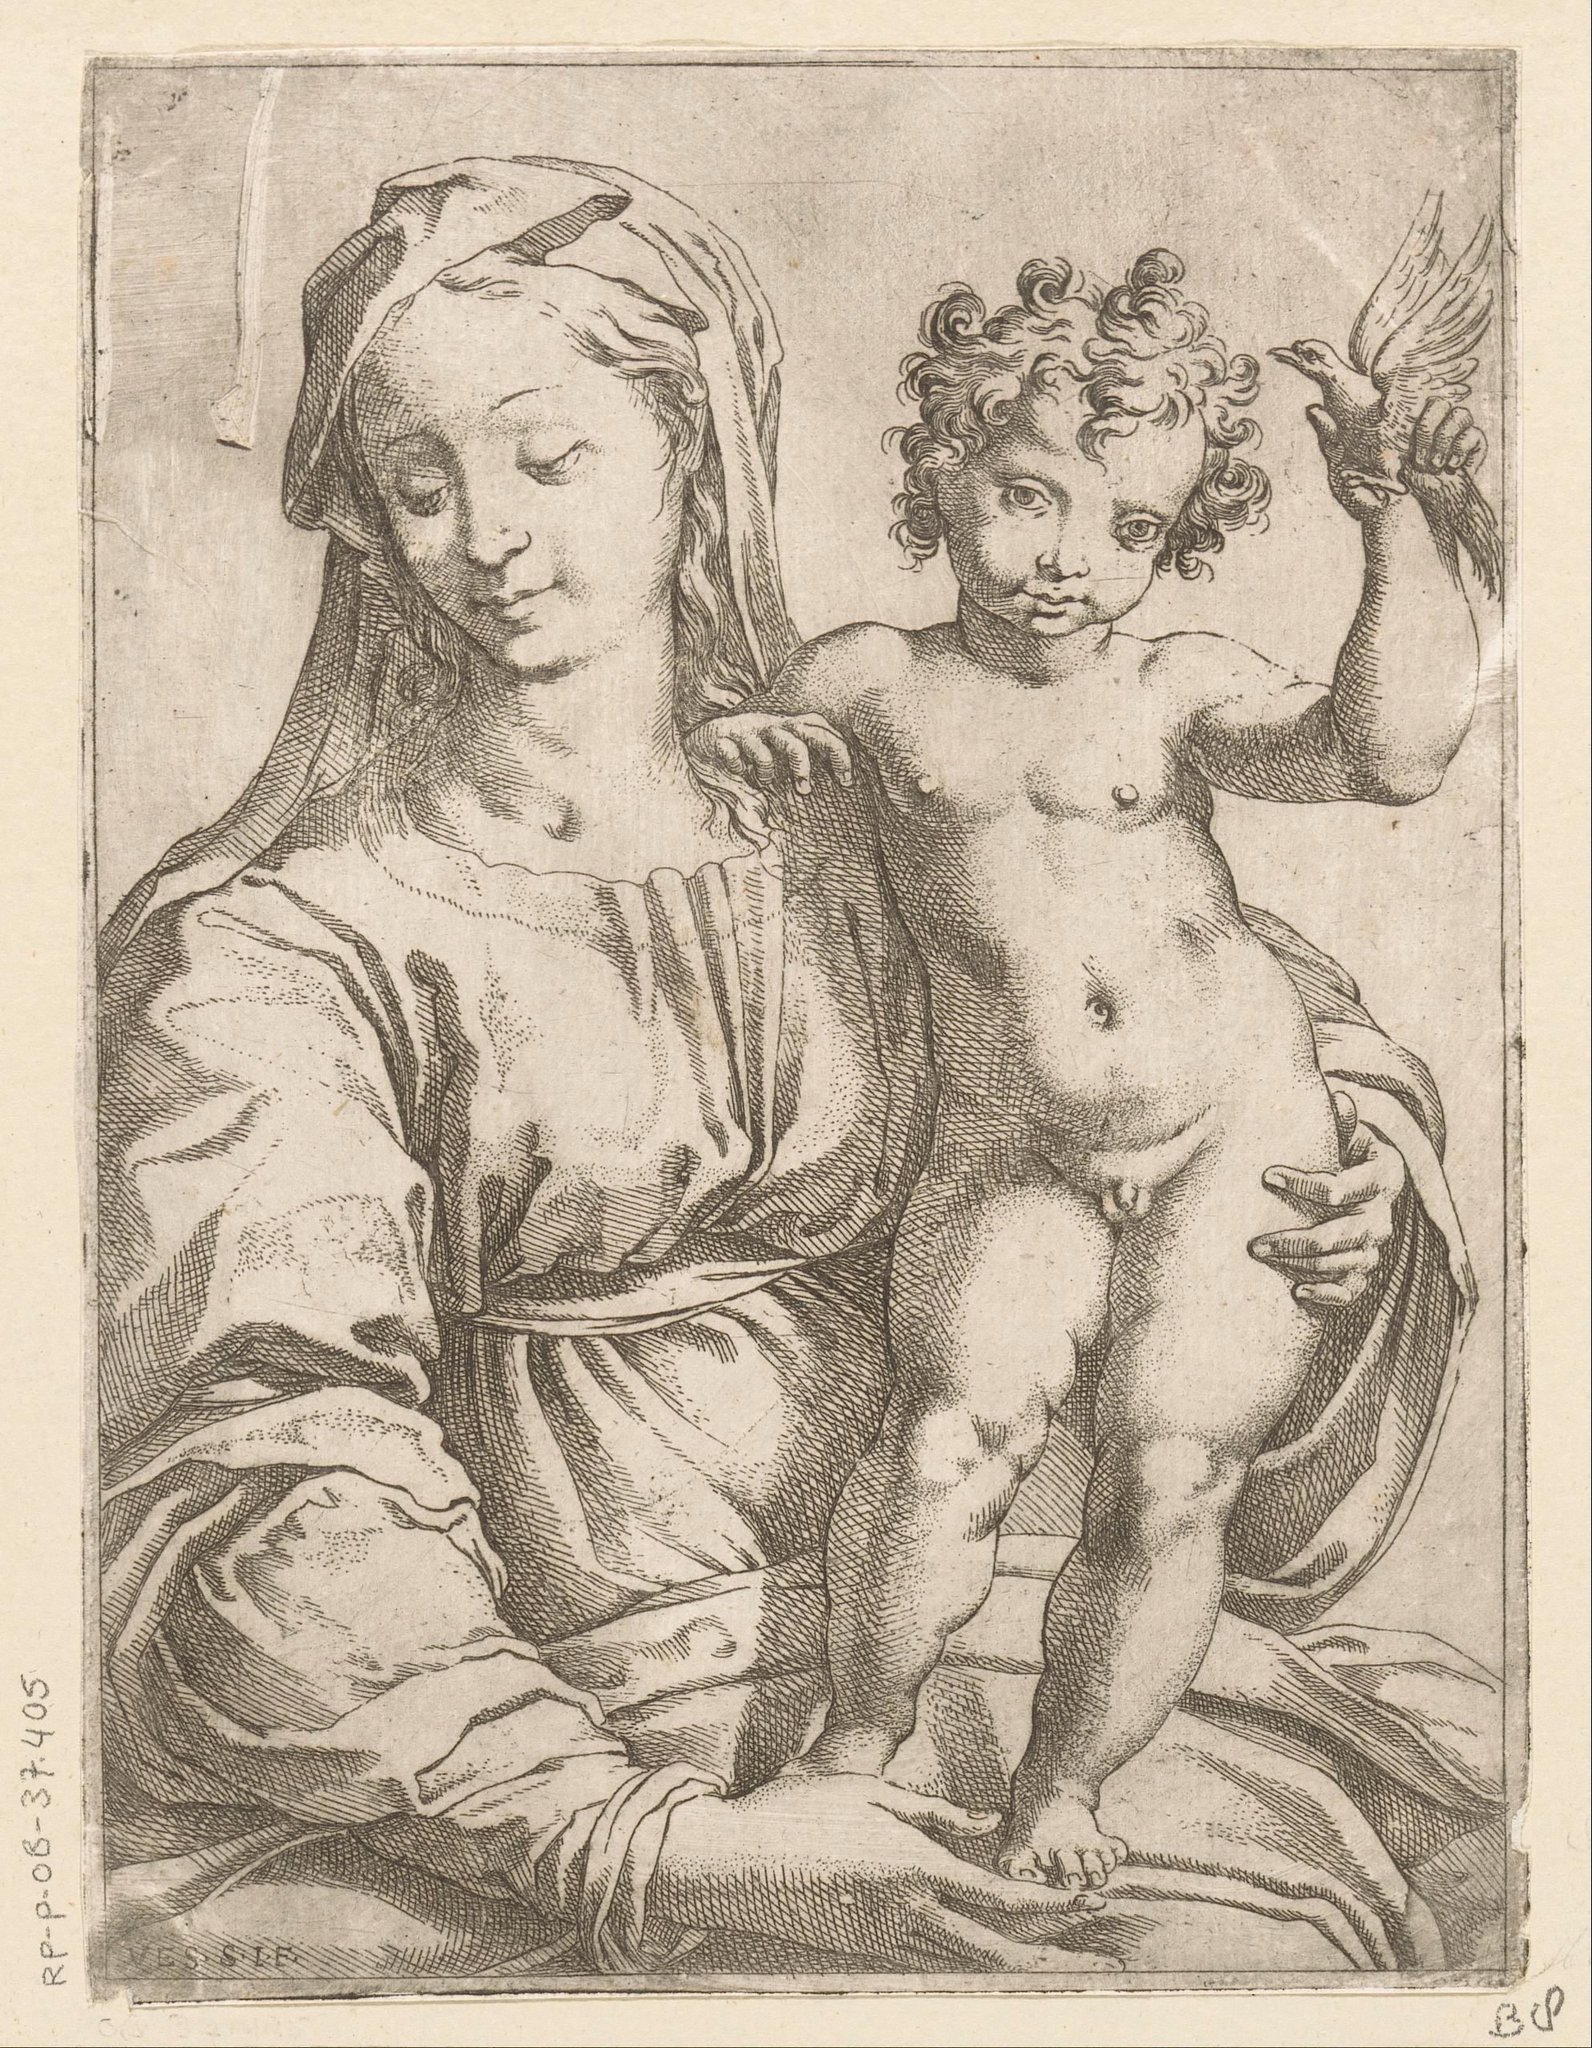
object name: print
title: Maria met Kind en een vogel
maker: vespasiano strada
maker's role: draughtsman, painter, print maker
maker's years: 1582-1622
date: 1592-1622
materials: paper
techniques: etching, intaglio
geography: italy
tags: madonna: i.e. mary with the christ-child, christ-child holding something in his hand, e.g. apple, bird, cherries, crucifix, grapes, paper wind-mill ~ madonna-representations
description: Maria zittend met het staande Christuskind op schoot. In zijn linkerhand houdt het Kind een vogel vast.